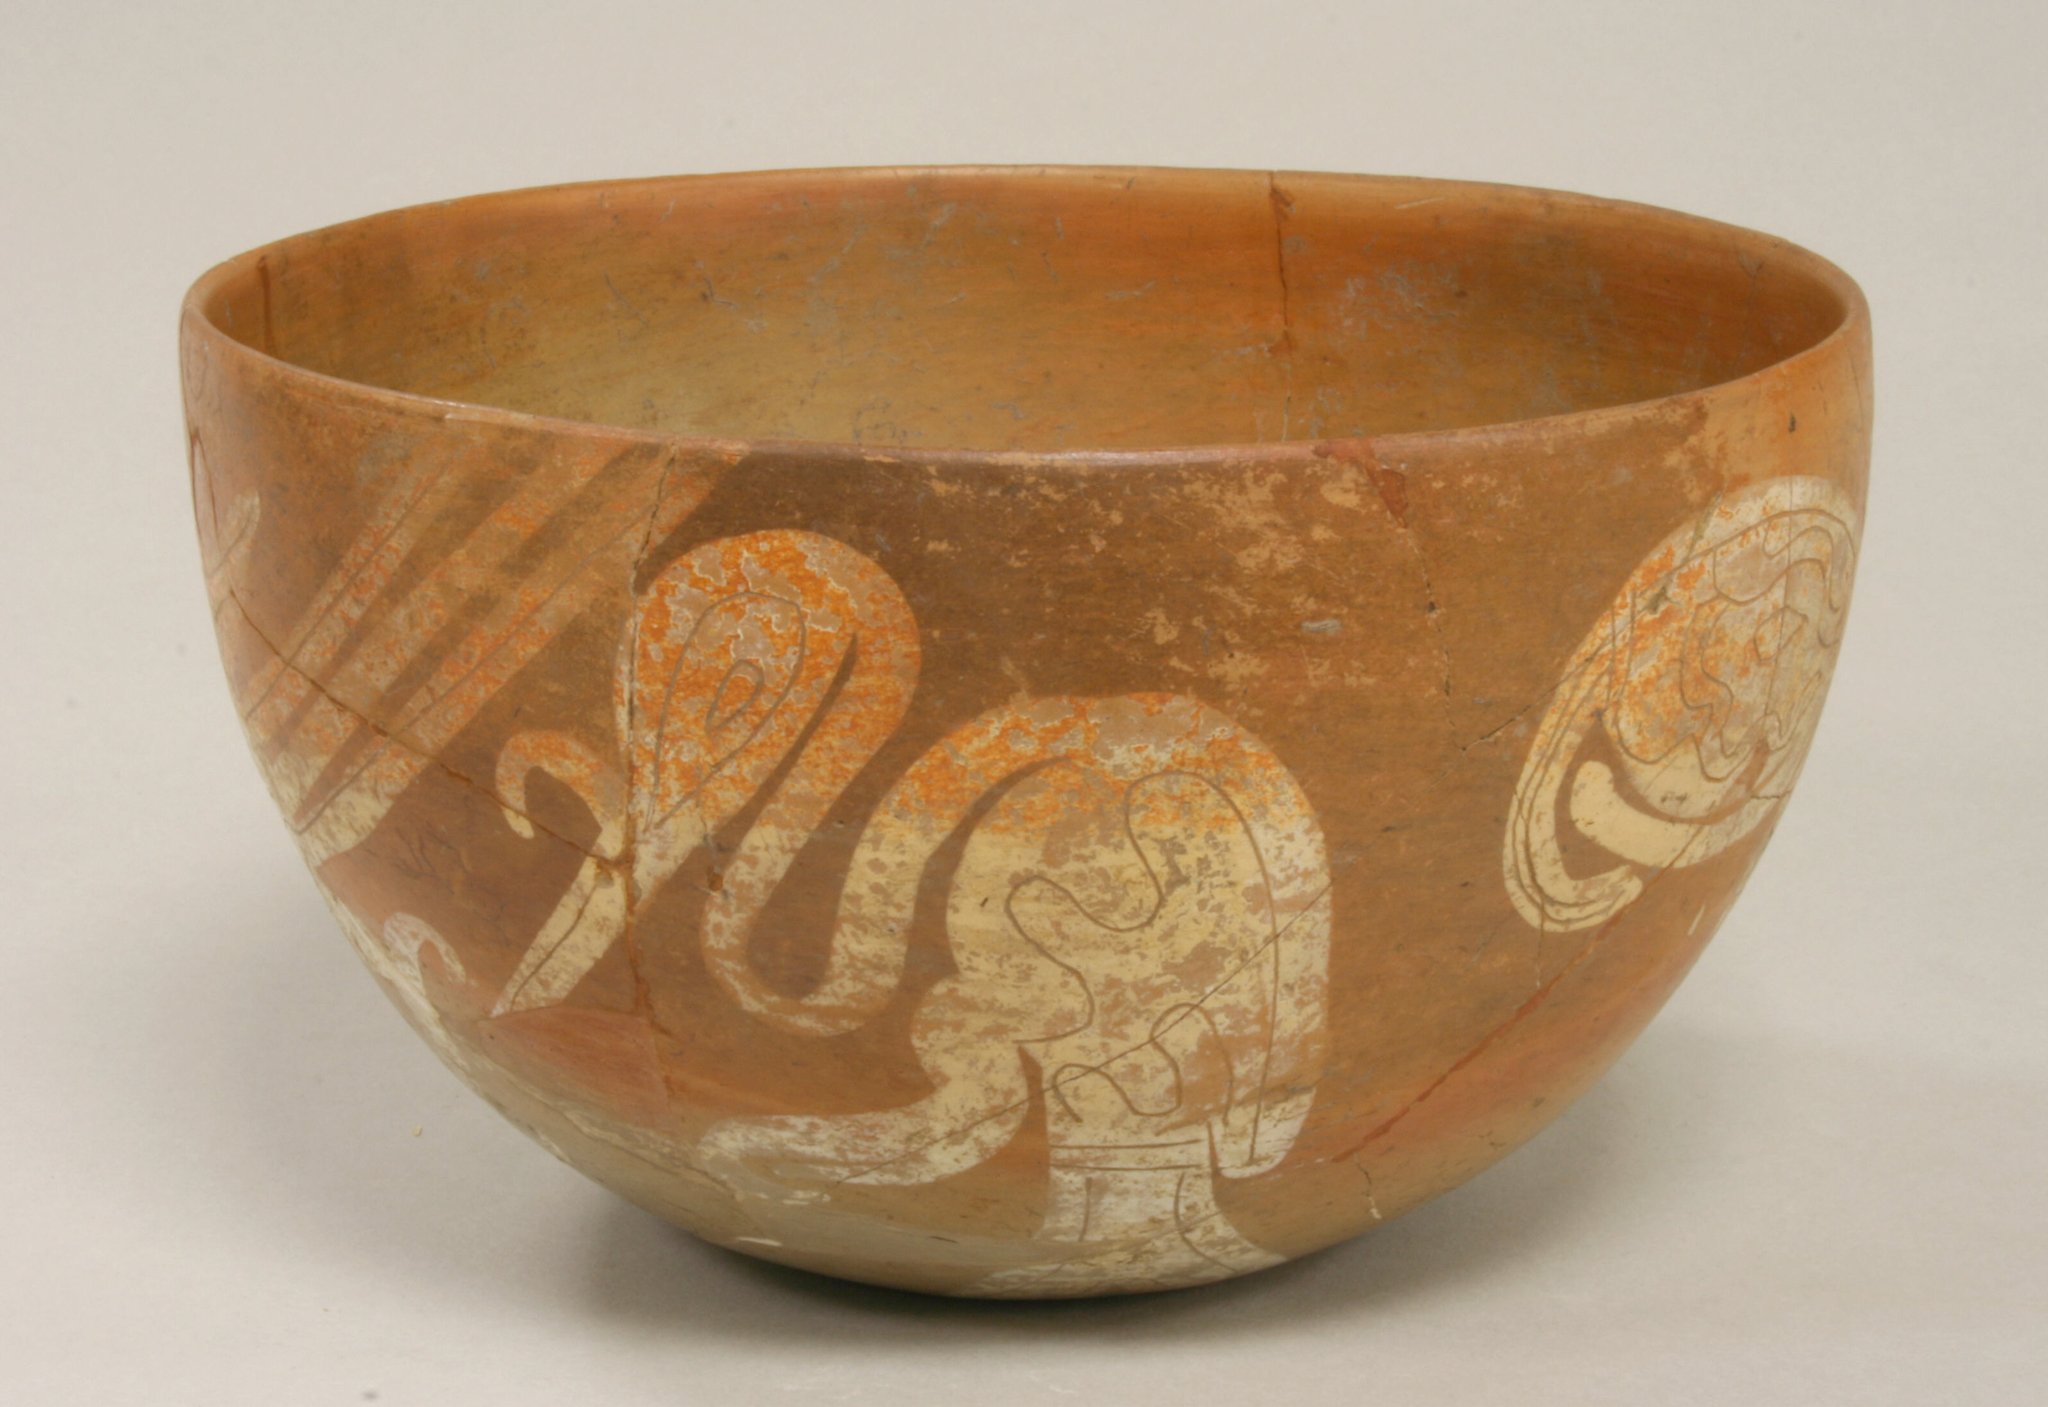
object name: bowl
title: Bowl with Bird Design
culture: nopiloa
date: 601-1000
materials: ceramic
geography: mexico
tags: birds